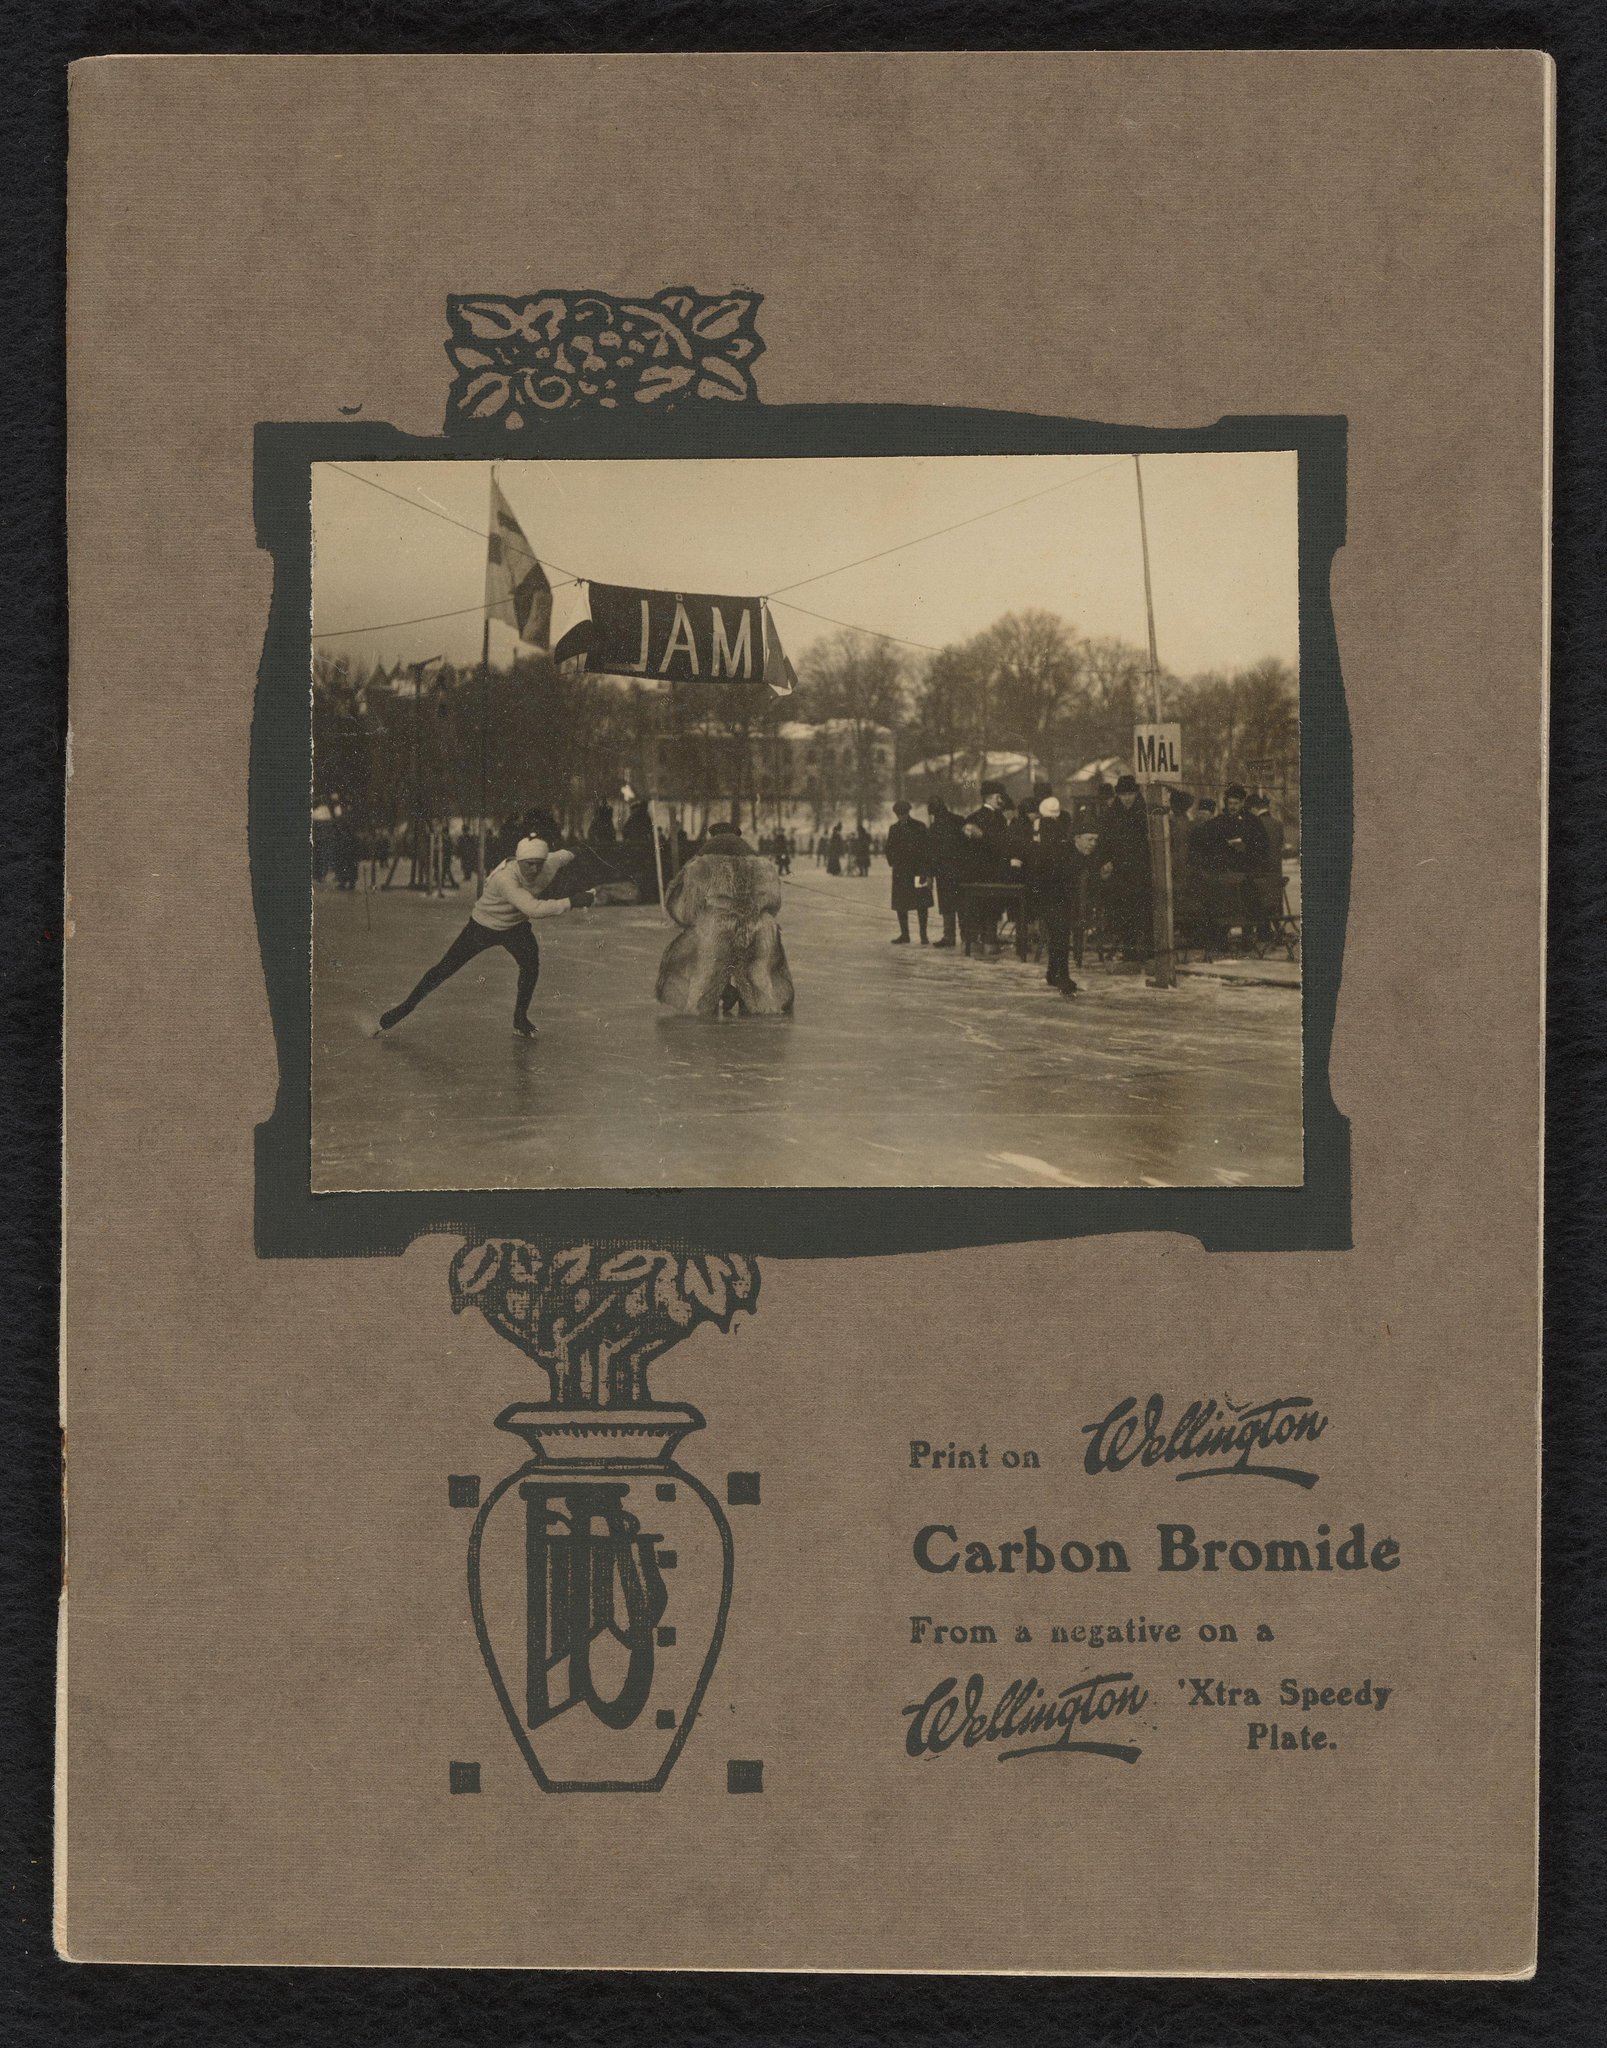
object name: page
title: Eindstreep van een schaatswedstrijd met publiek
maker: Anonymous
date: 1900-1905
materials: paper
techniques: gelatin silver print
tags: crowd, mob, skates (winter sports), ice ~ state of water, norway